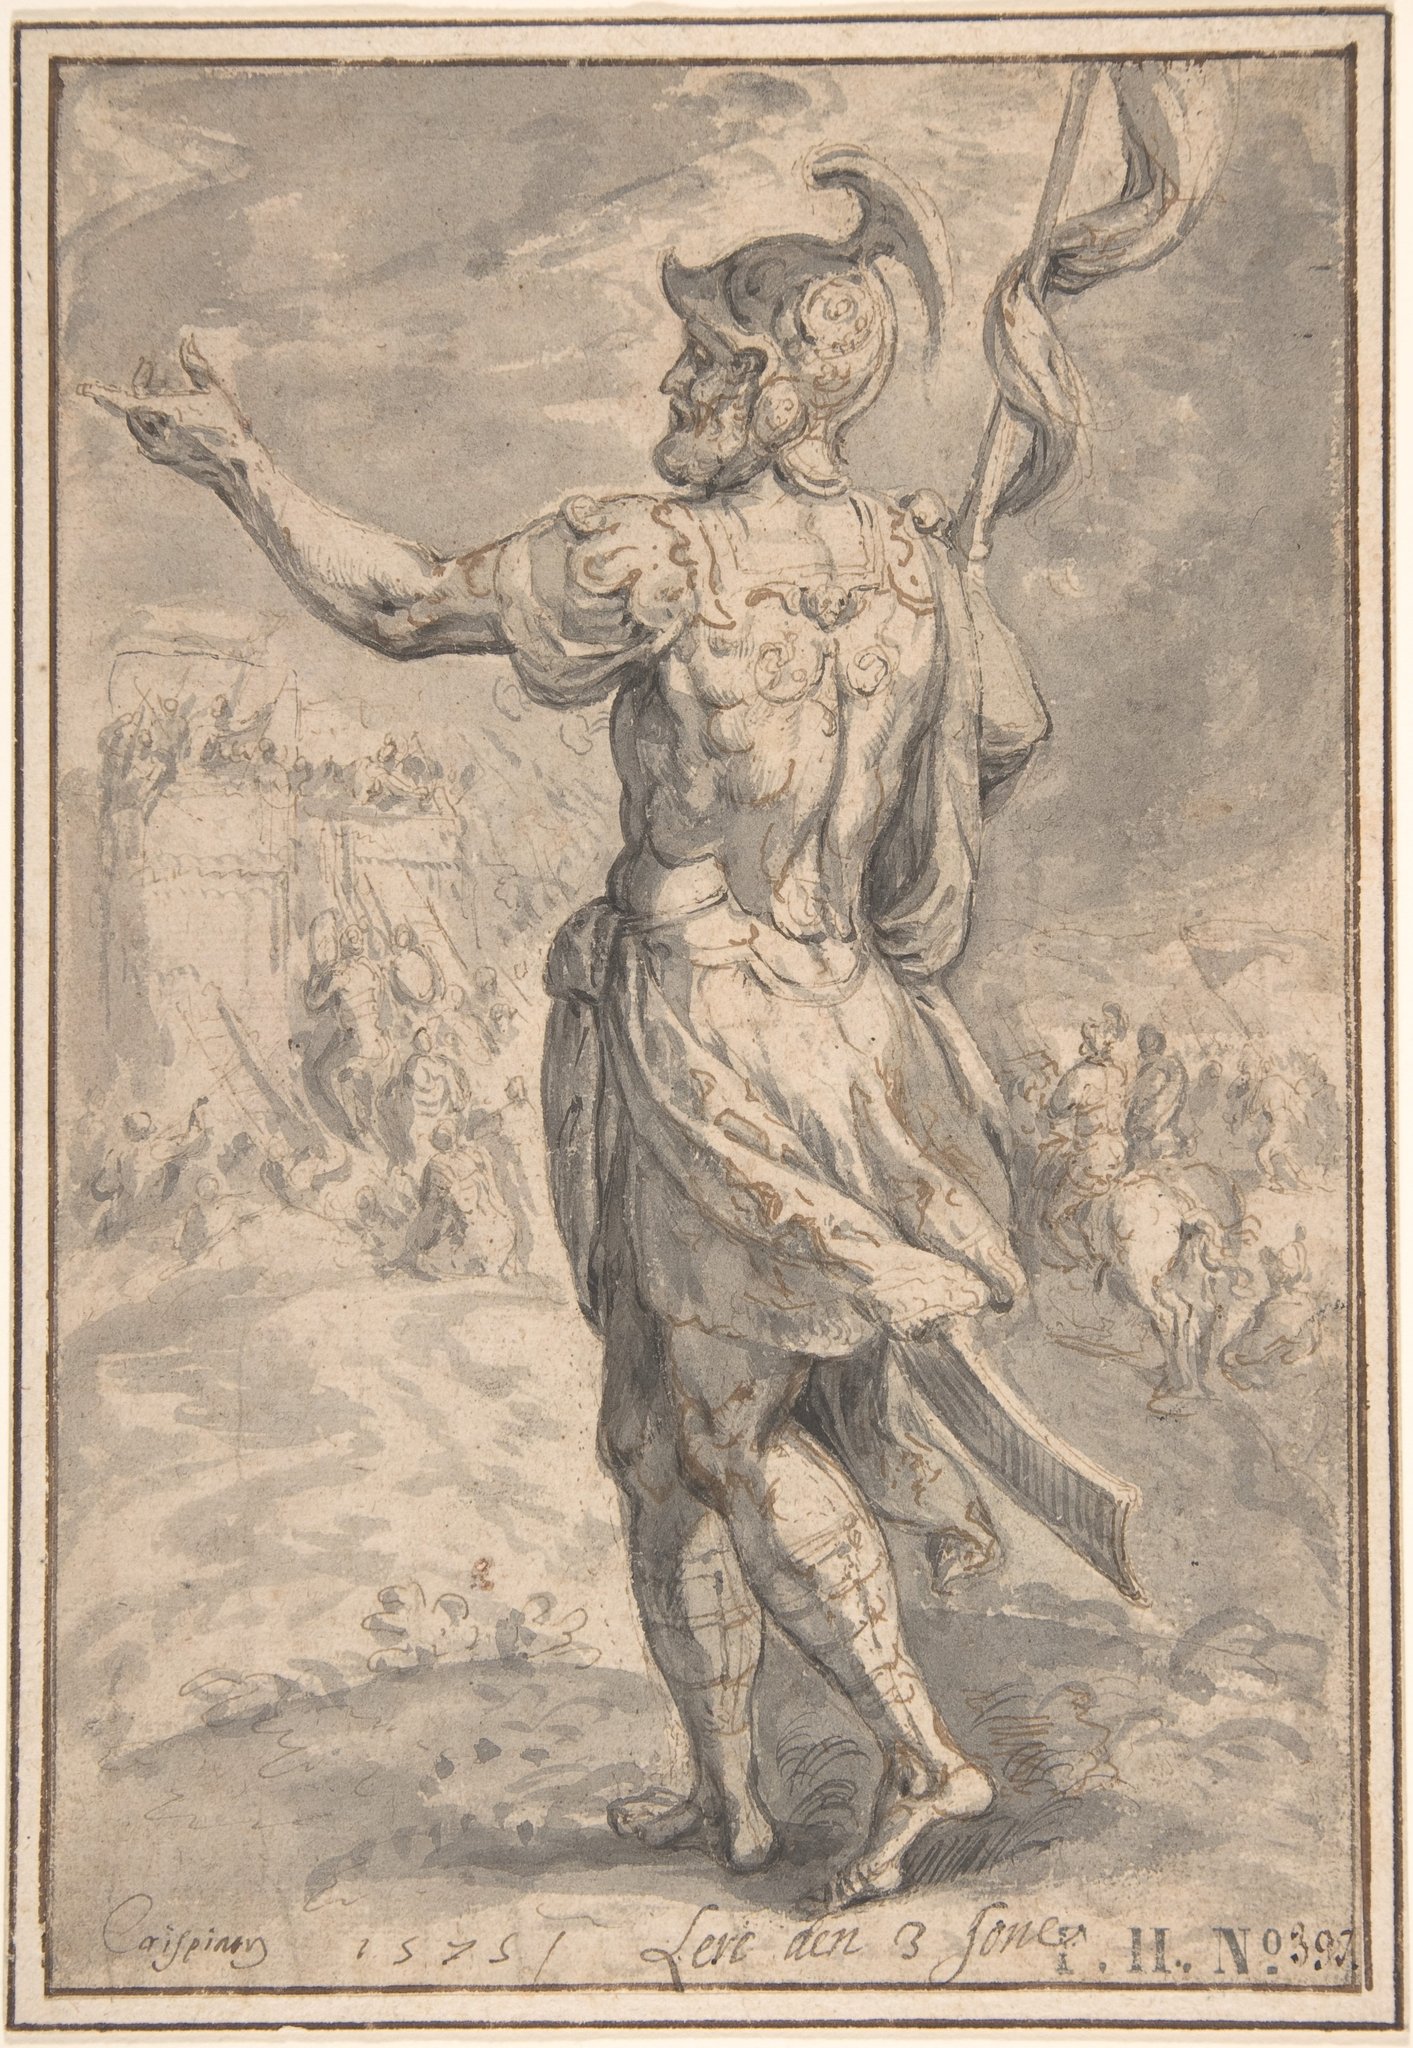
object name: drawing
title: Levi Avenging the Honor of his Sister Dinah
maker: crispijn van den broeck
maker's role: artist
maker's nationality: netherlandish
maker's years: 1524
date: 1501-1600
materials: chalk, ink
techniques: pen, transfer, wash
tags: men,horses,crowd